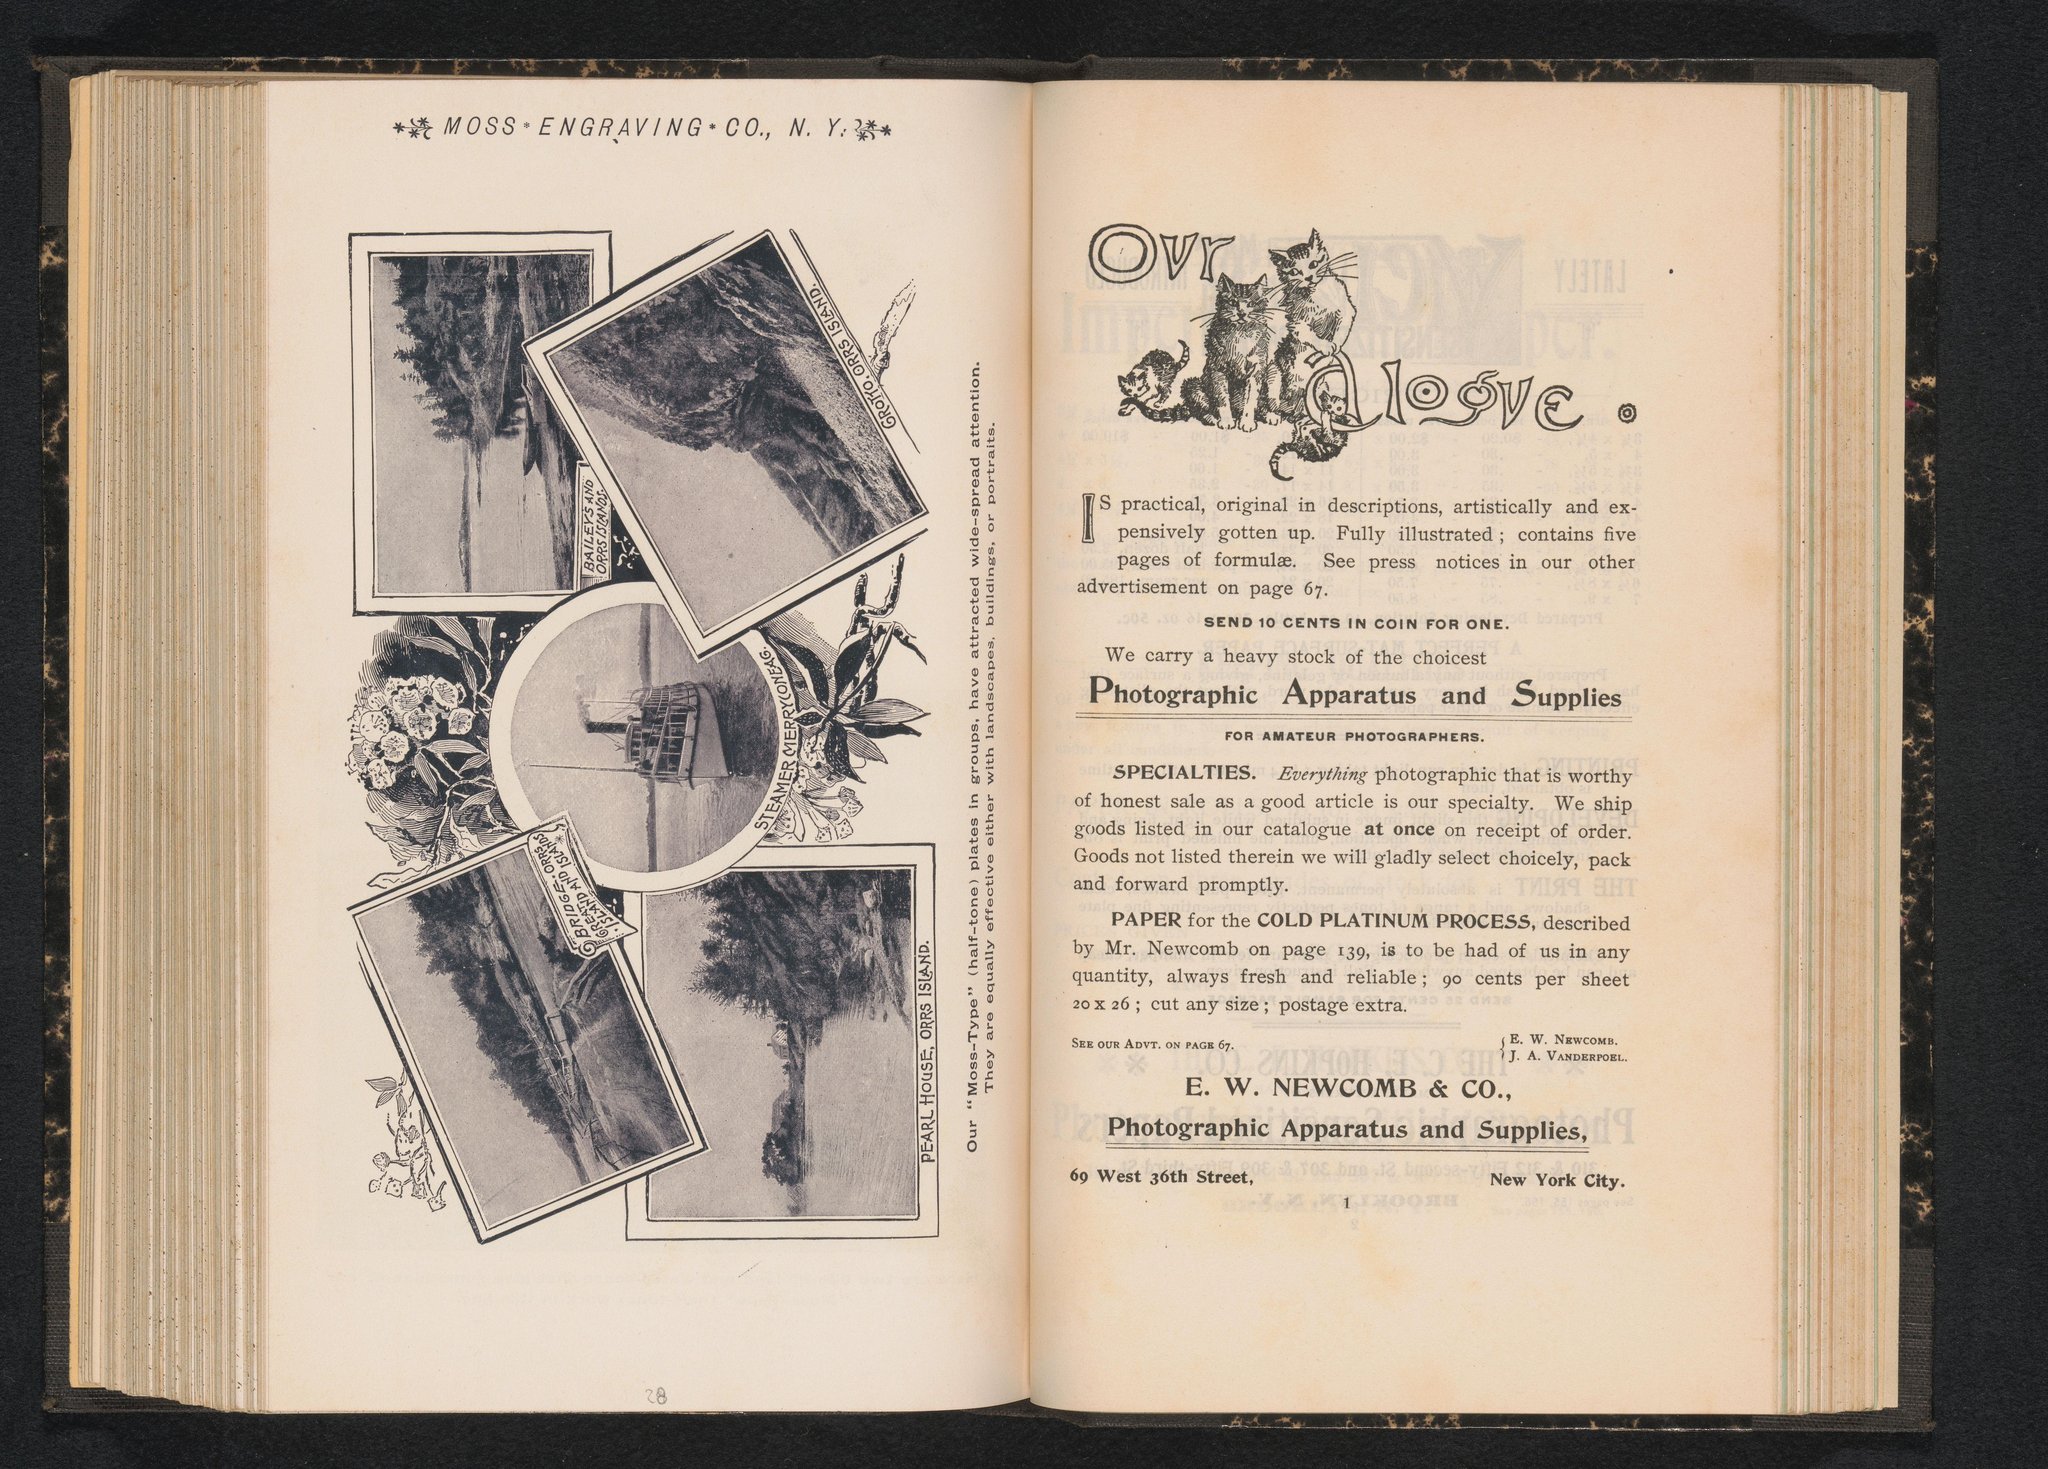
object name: photomechanical print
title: Collage van landschappen bij Orr's Island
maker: Anonymous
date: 1887-1907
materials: paper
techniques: autotype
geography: orr's island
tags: island, landscapes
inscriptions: inscription: ‘Pearl House, Orr's Island/ Bridge, Great Island and Orr's Islands/ Baileys and Orr's Islands/ Steamer Merryconeag/ Grotto, Orr's Island’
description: Prent op vijfde ongenummerde pagina na pagina 393.